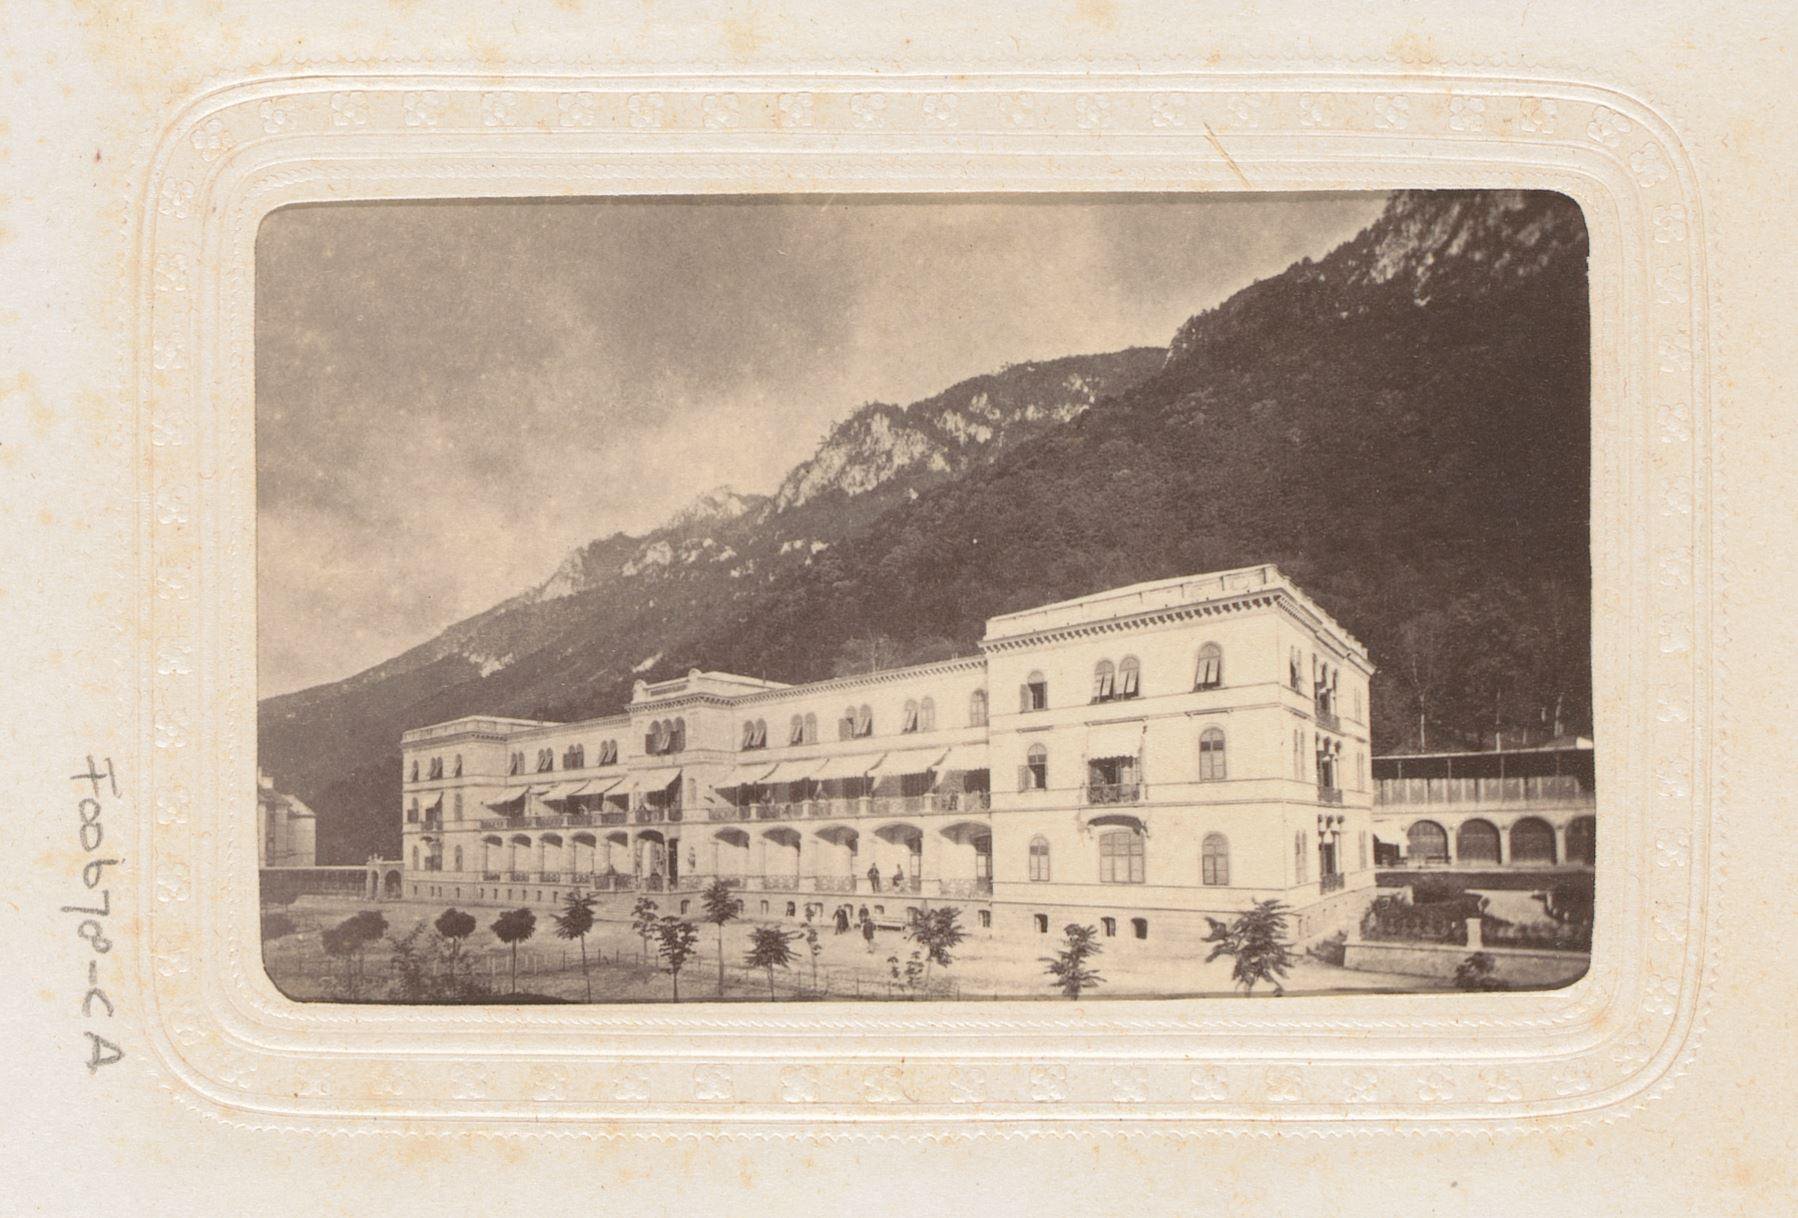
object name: album leaf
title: Gezicht op het Franz Josef-Hof te Băile Herculane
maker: carl händl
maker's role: fotograaf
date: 1860-1880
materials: cardboard, photographic support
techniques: albumen print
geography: băile herculane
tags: city-view in general; 'veduta', mountains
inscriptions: annotation: ‘Franz-Josef-Hof’, annotation: ‘Uchadia’, inscription: ‘Herculesbad./ Augenommen von Carl Händl,/ Photograph’